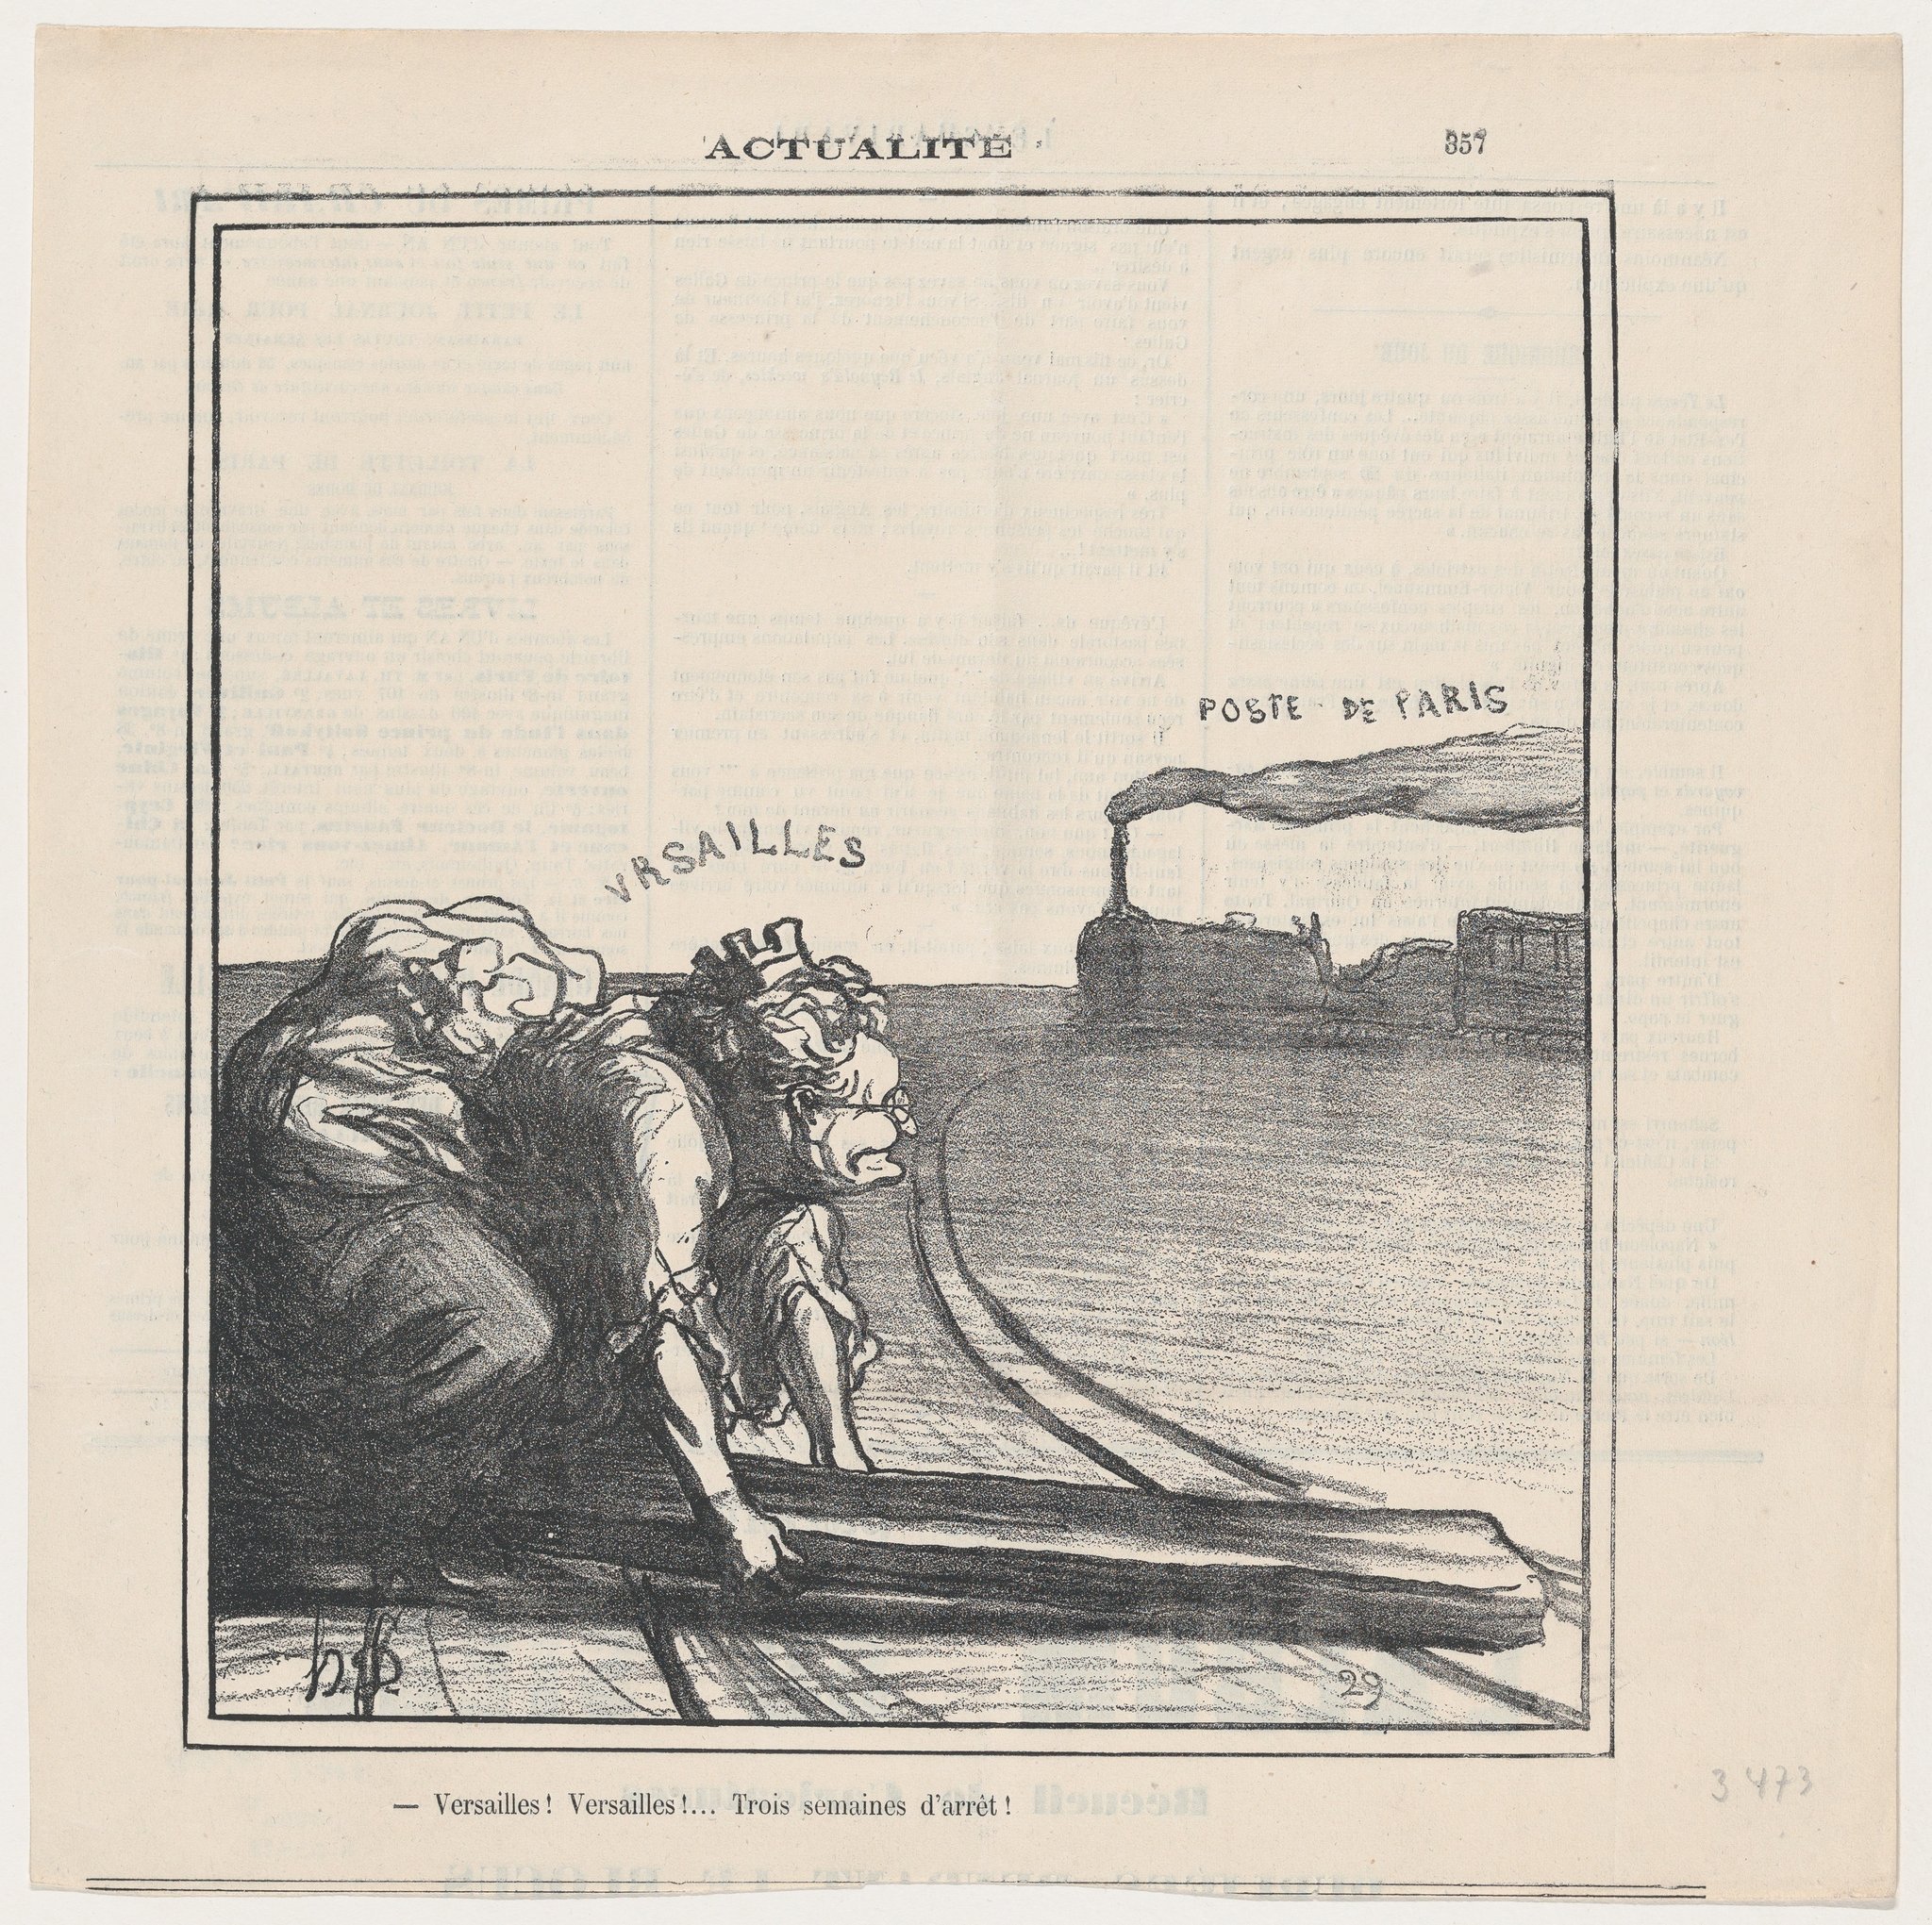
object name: print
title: Versailles! Versailles!... Three weeks of interruption, from 'News of the day,' published in "Le Charivari"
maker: honoré daumier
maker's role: artist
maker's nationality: french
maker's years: 1808-1879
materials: paper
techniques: lithograph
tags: satire,women,trains